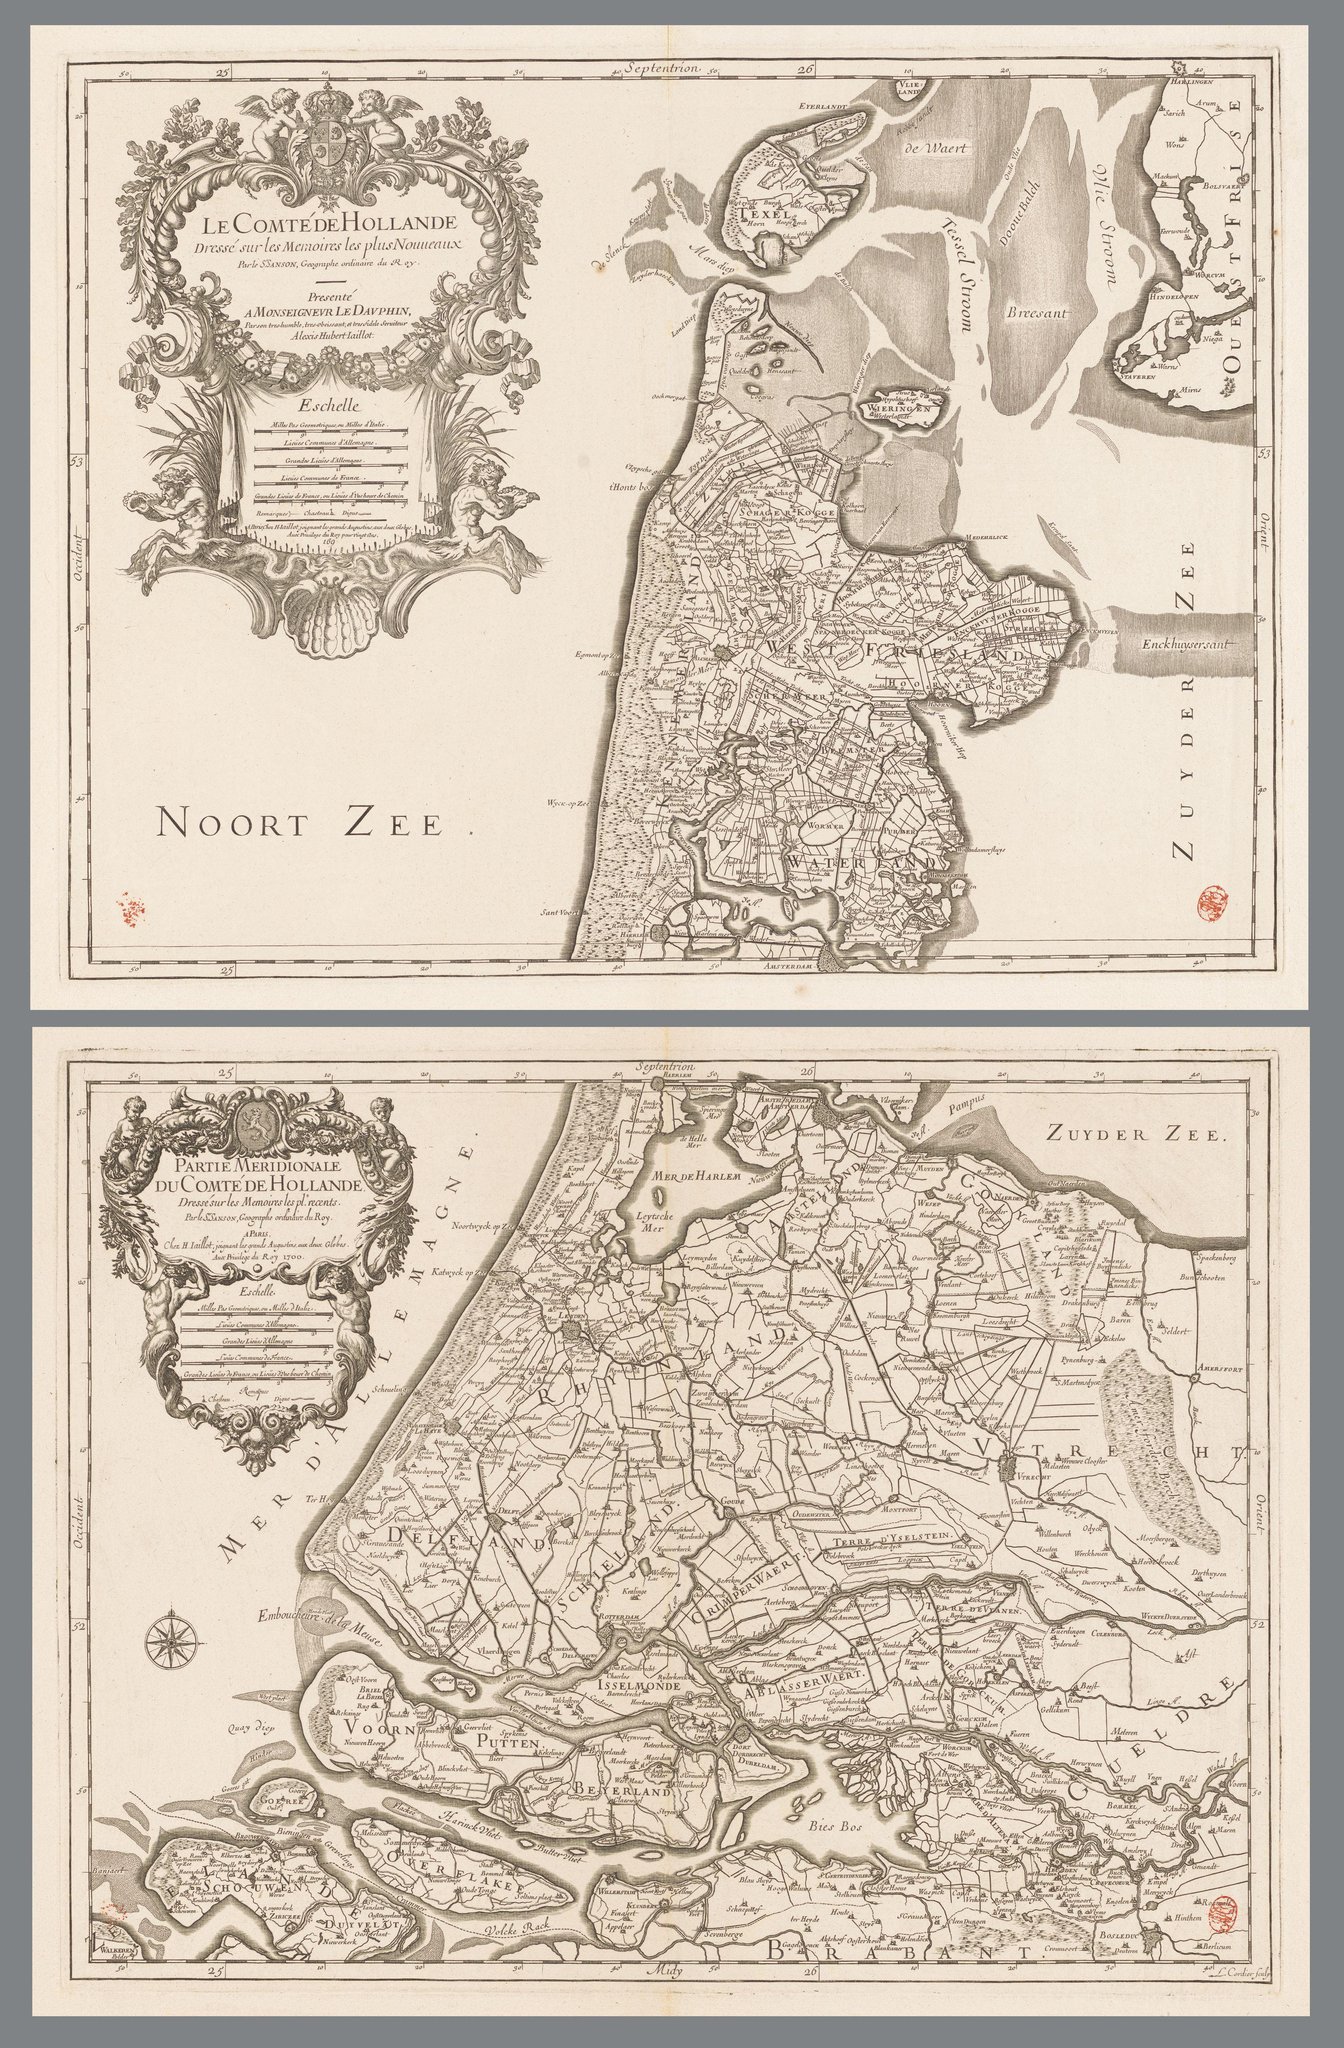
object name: map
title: Kaart van het graafschap Holland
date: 1690-1700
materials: paper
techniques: engraving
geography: paris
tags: coat of arms (as symbol of the state, etc.), maps of separate countries or regions, satyr(s) (in general), holland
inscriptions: watermark, collector's mark: Lugt 195, watermark: ‘Rozenkrans met in cirkel een Maltees kruis, aan het uiteinde hangt een Grieks kruis (Petit of Grand Chapelet?).’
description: Dit object is omwille van een betere presentatie virtueel samengevoegd maar bestaat fysiek uit losse onderdelen. Deze kaart bestaat uit twee bladen die los van elkaar zijn uitgegeven en ieder als enkele kaart gebruikt konden worden of samen konden worden gevoegd tot een kaart van het graafschap Holland. Van beide kaarten zijn verschillende staten bekend. De combinatie van de staten van deze twee exemplaren komt voor in: Atlas françois contenant les cartes geographiques dans lesquelles sont tres exactement remarquez les empires, monarchies, royaumes et estats (…). Parijs: Alexis Hubert Jaillot, 1700.